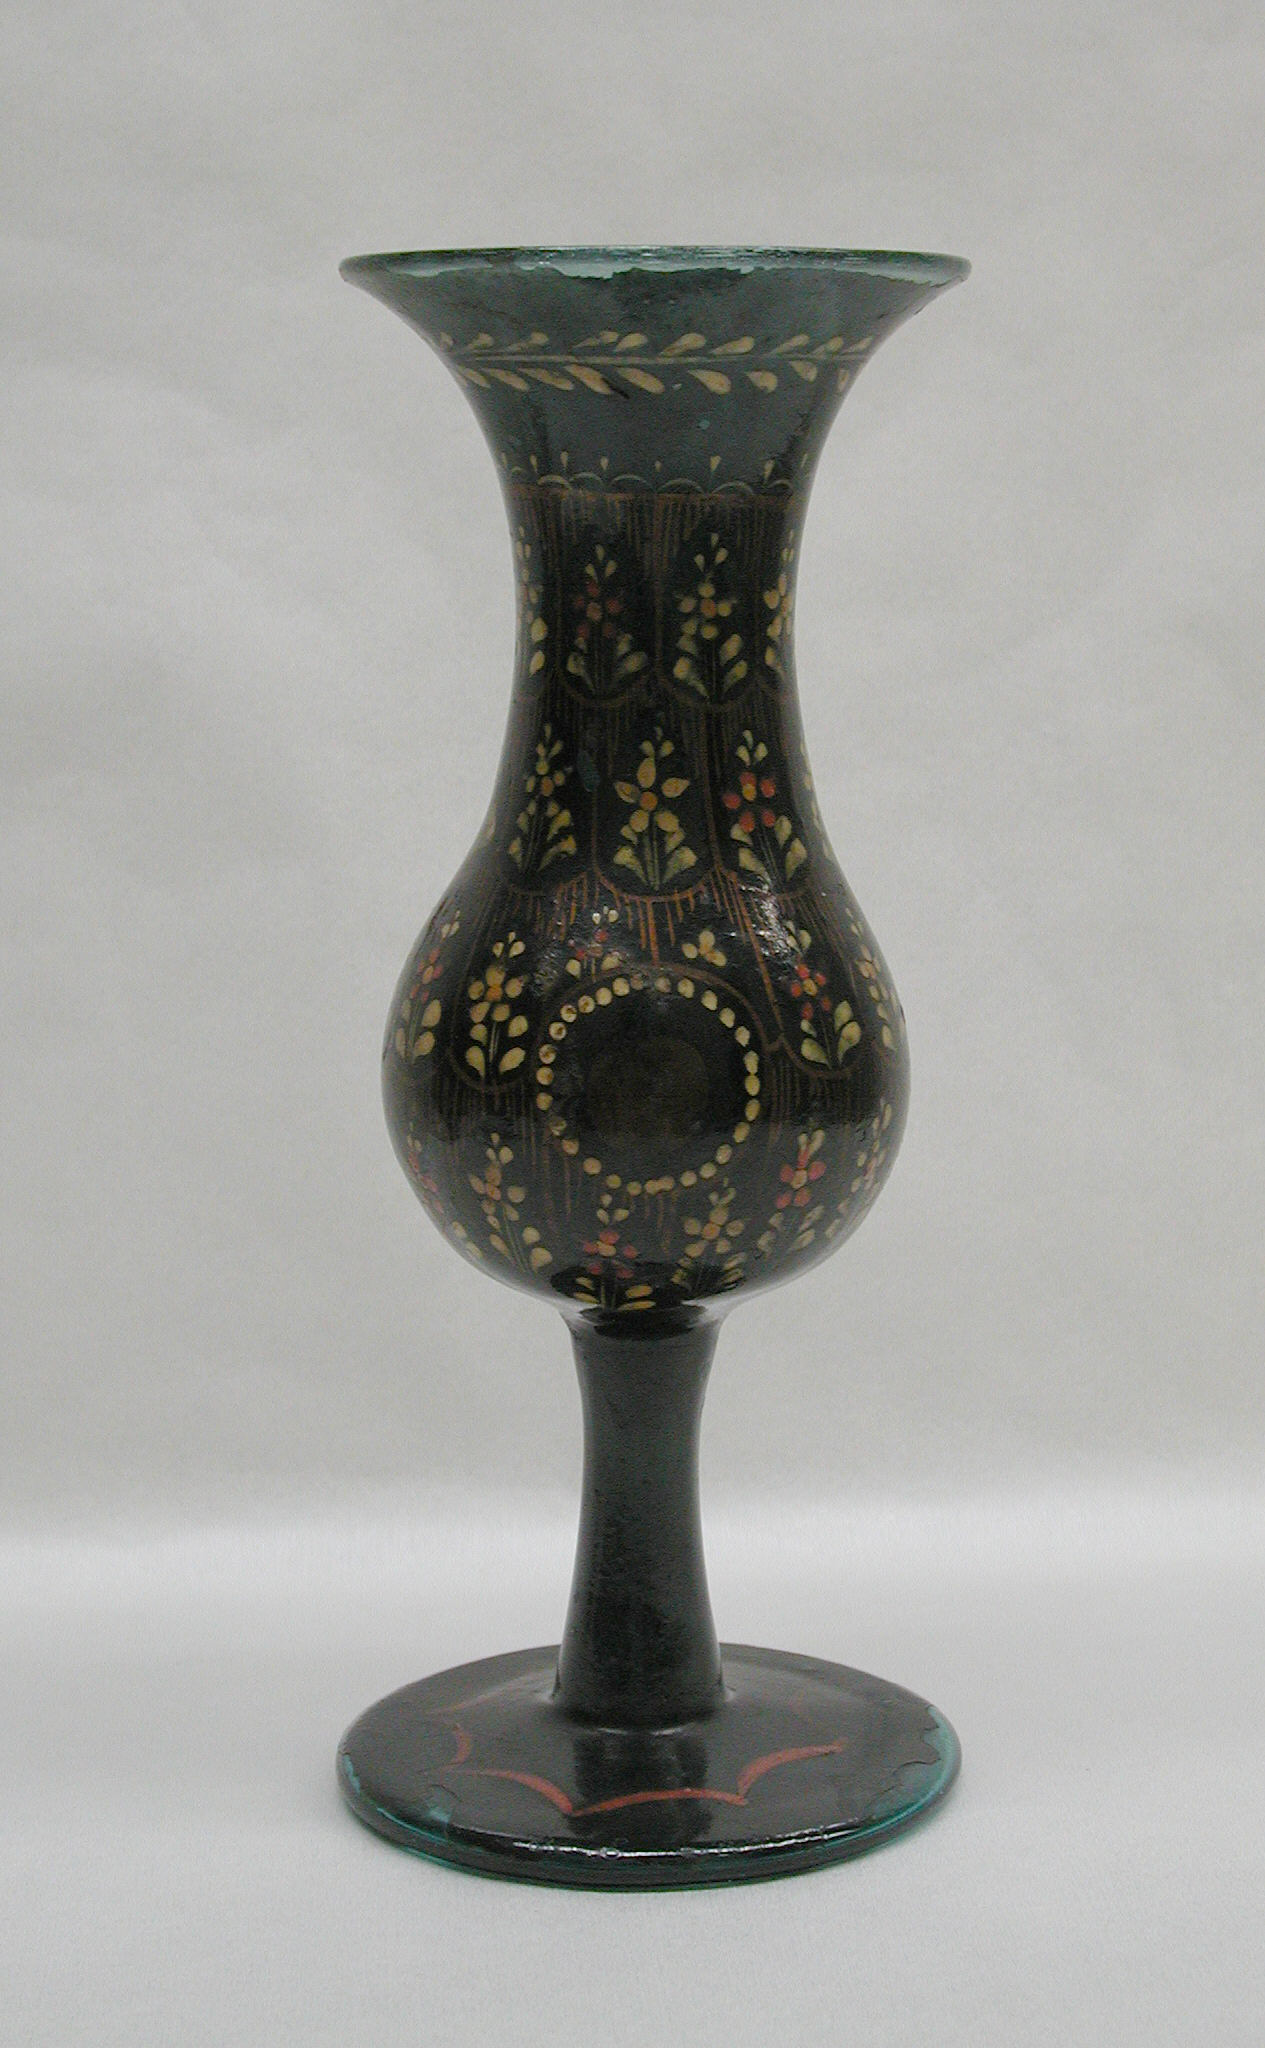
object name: altar vase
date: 1820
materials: glass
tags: flowers